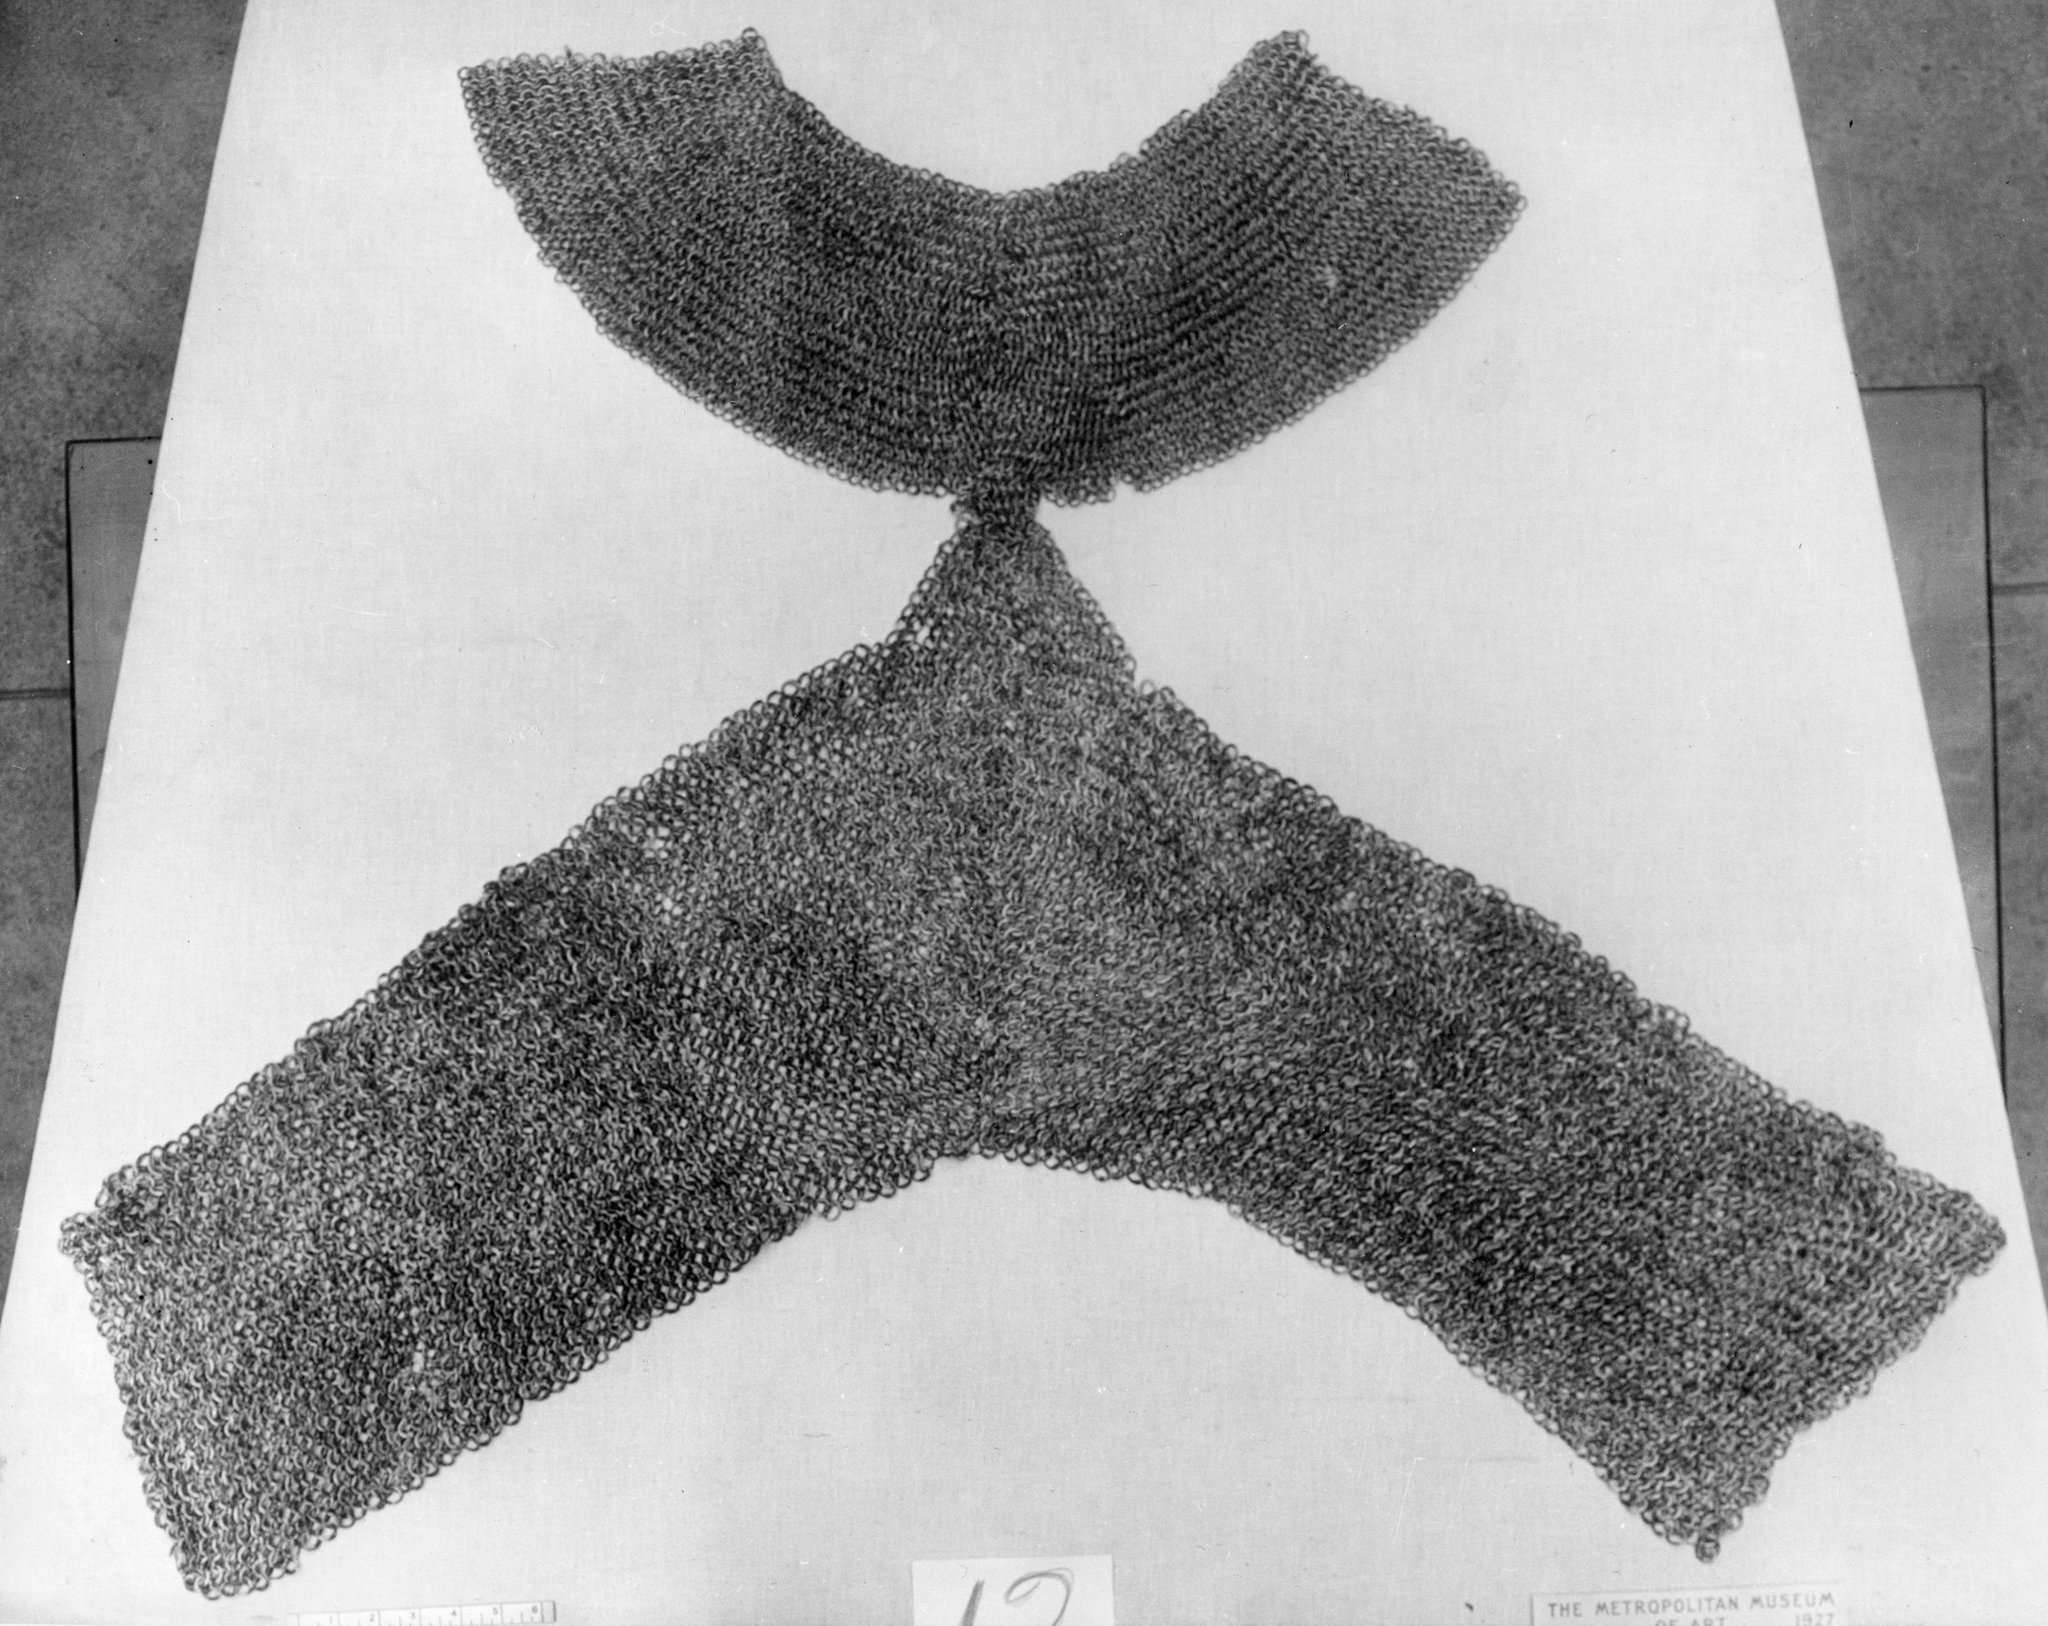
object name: brayette and buttock defense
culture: german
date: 1501-1600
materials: copper alloy, iron, steel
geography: germany